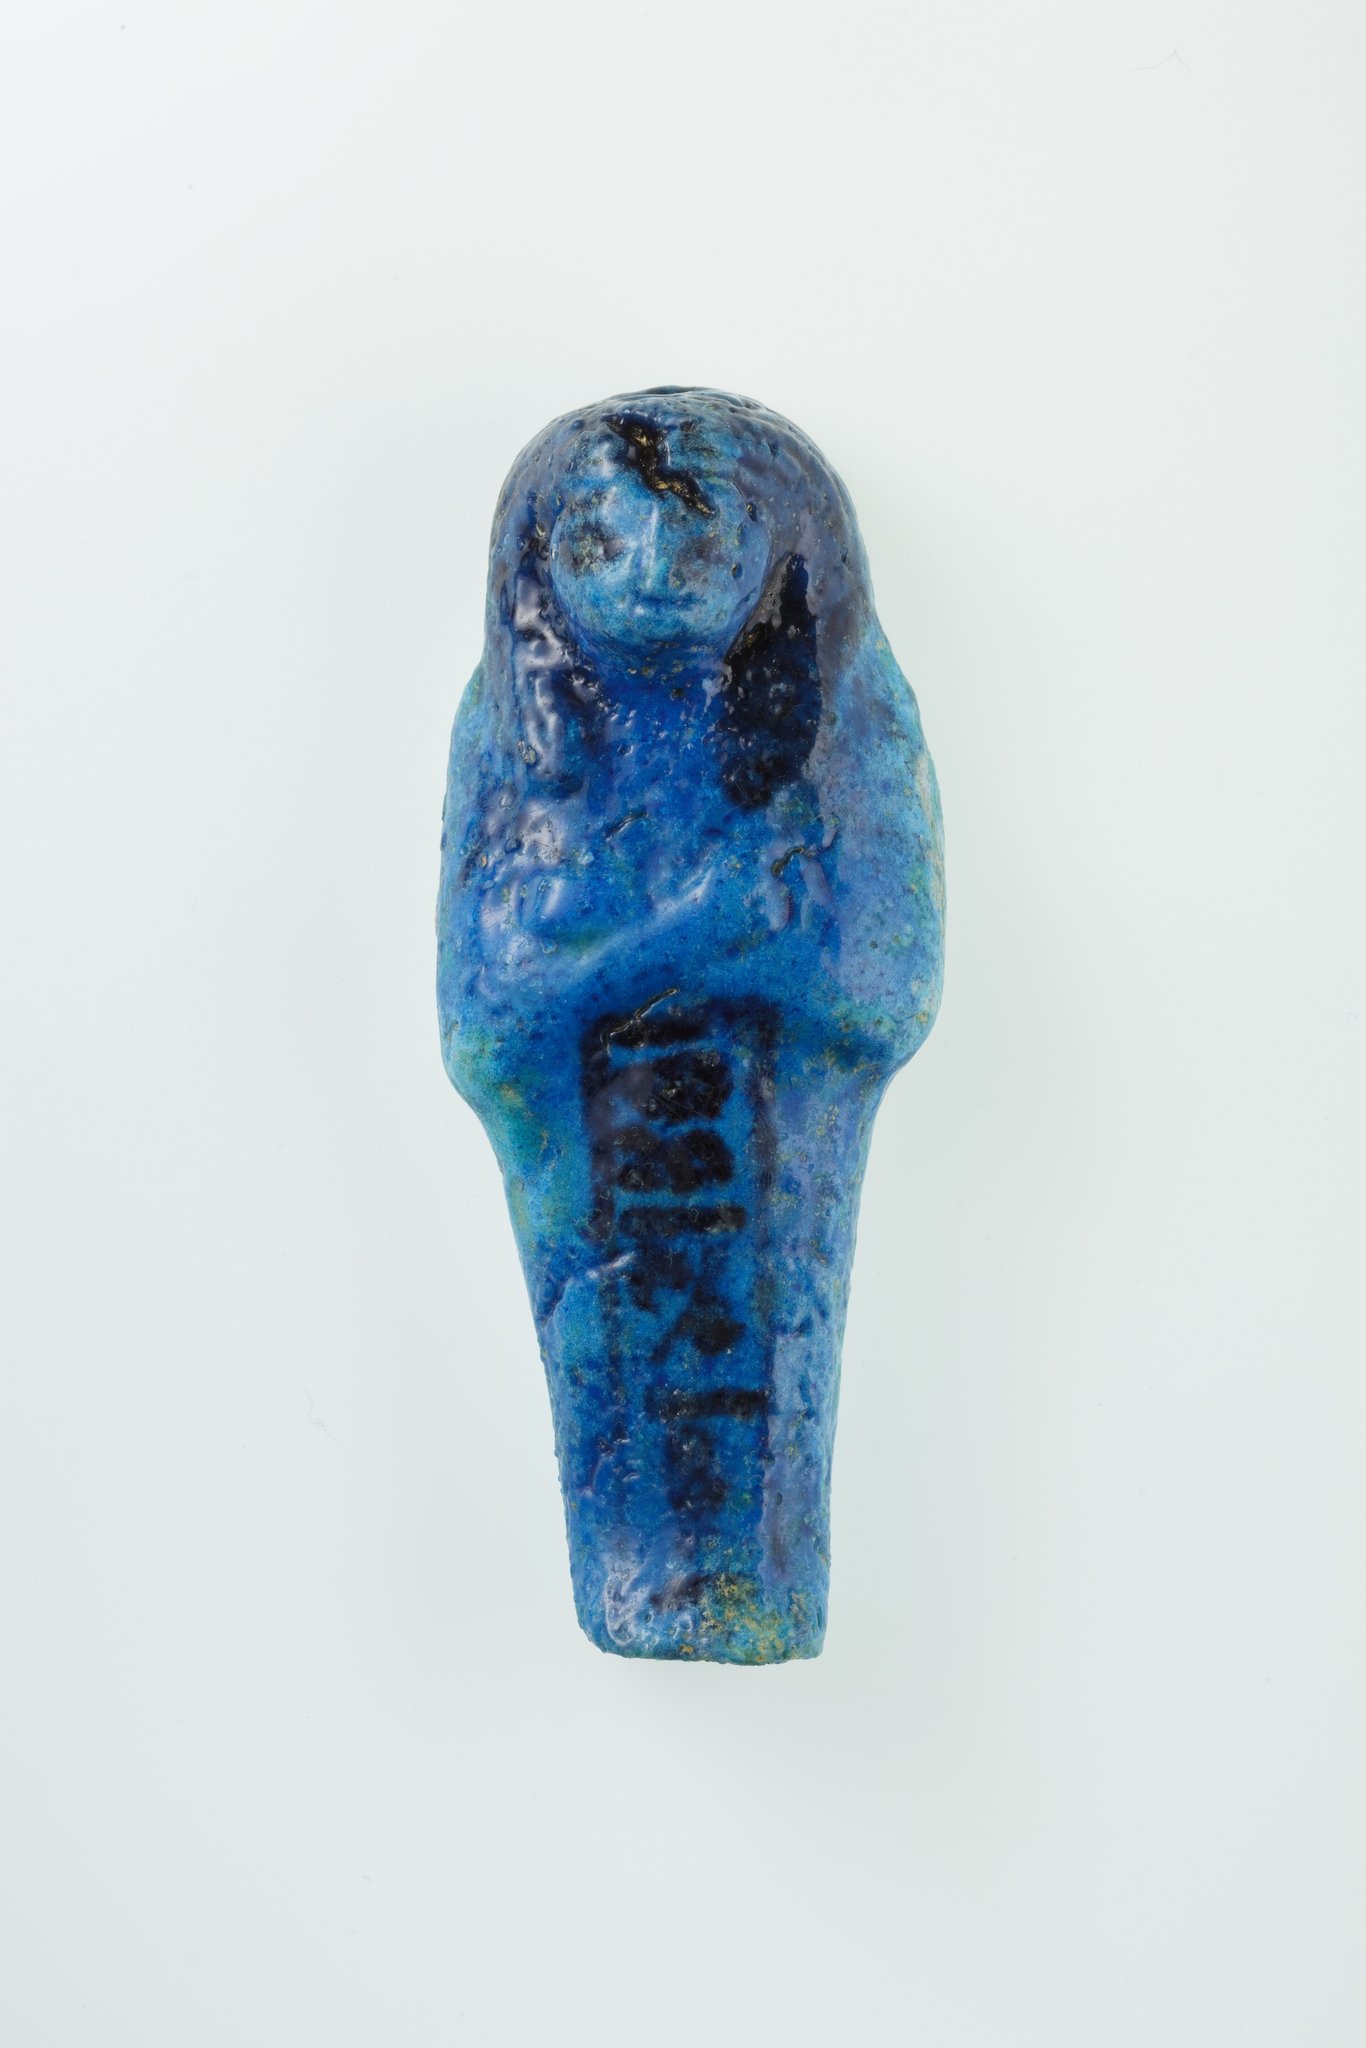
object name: shabti, worker, nauny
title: Worker Shabti of Nauny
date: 1050 BCE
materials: faience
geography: egypt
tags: hieroglyphs